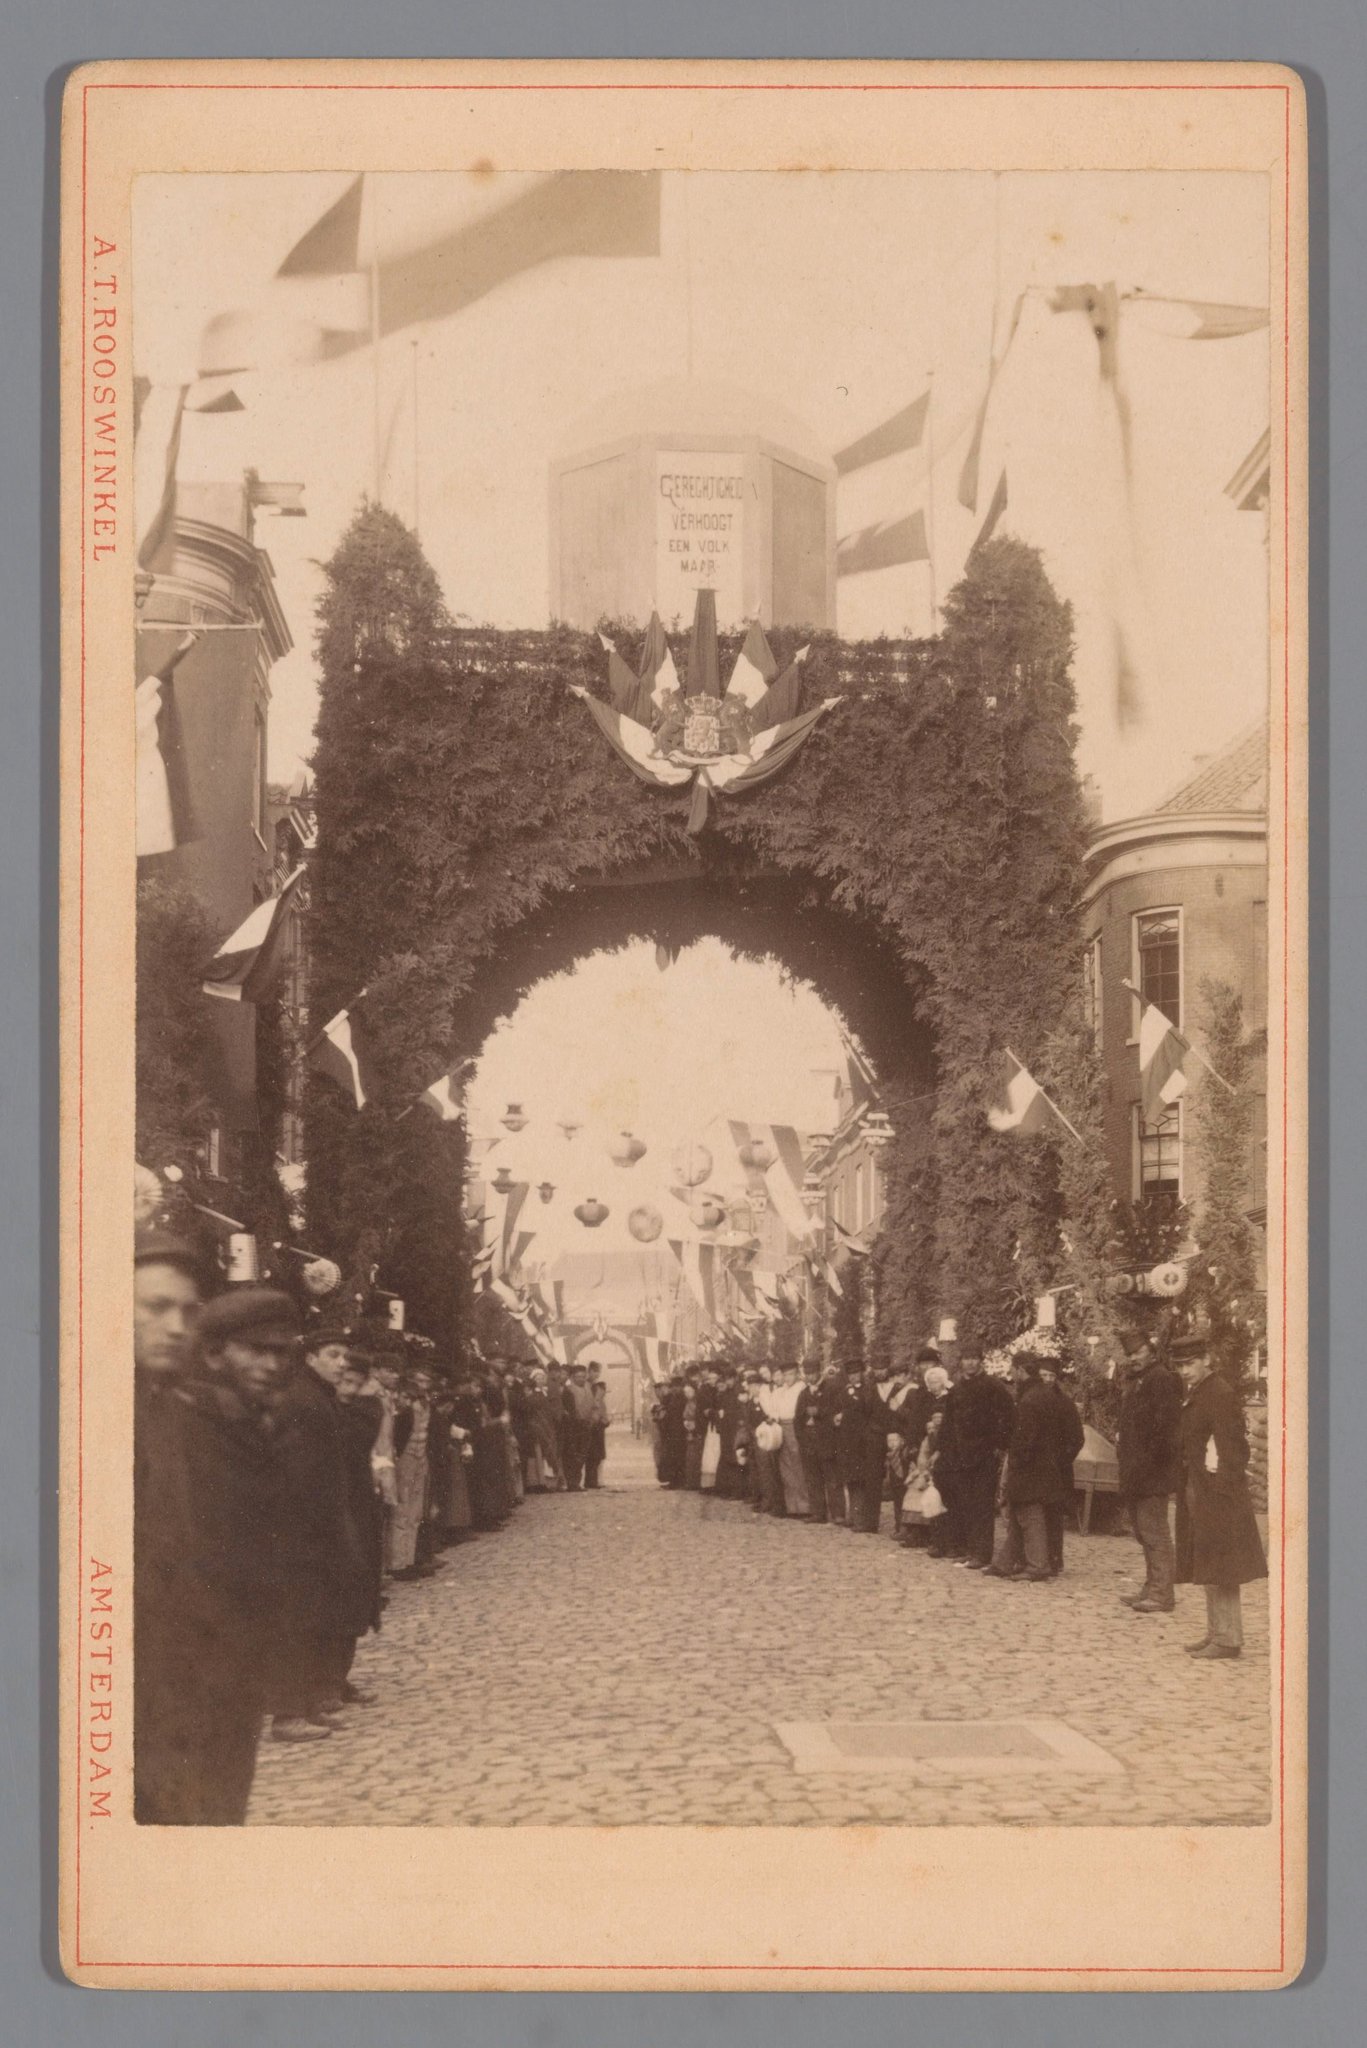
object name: photograph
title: Gezicht op de Willemsstraat in Amsterdam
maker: andreas theodorus rooswinkel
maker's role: fotograaf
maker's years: 1838-1909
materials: cardboard, photographic support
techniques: albumen print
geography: amsterdam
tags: village-gate, street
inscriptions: annotation: ‘A'dam/ 12-18/ April 1889’, annotation: ‘Willemsstraat’